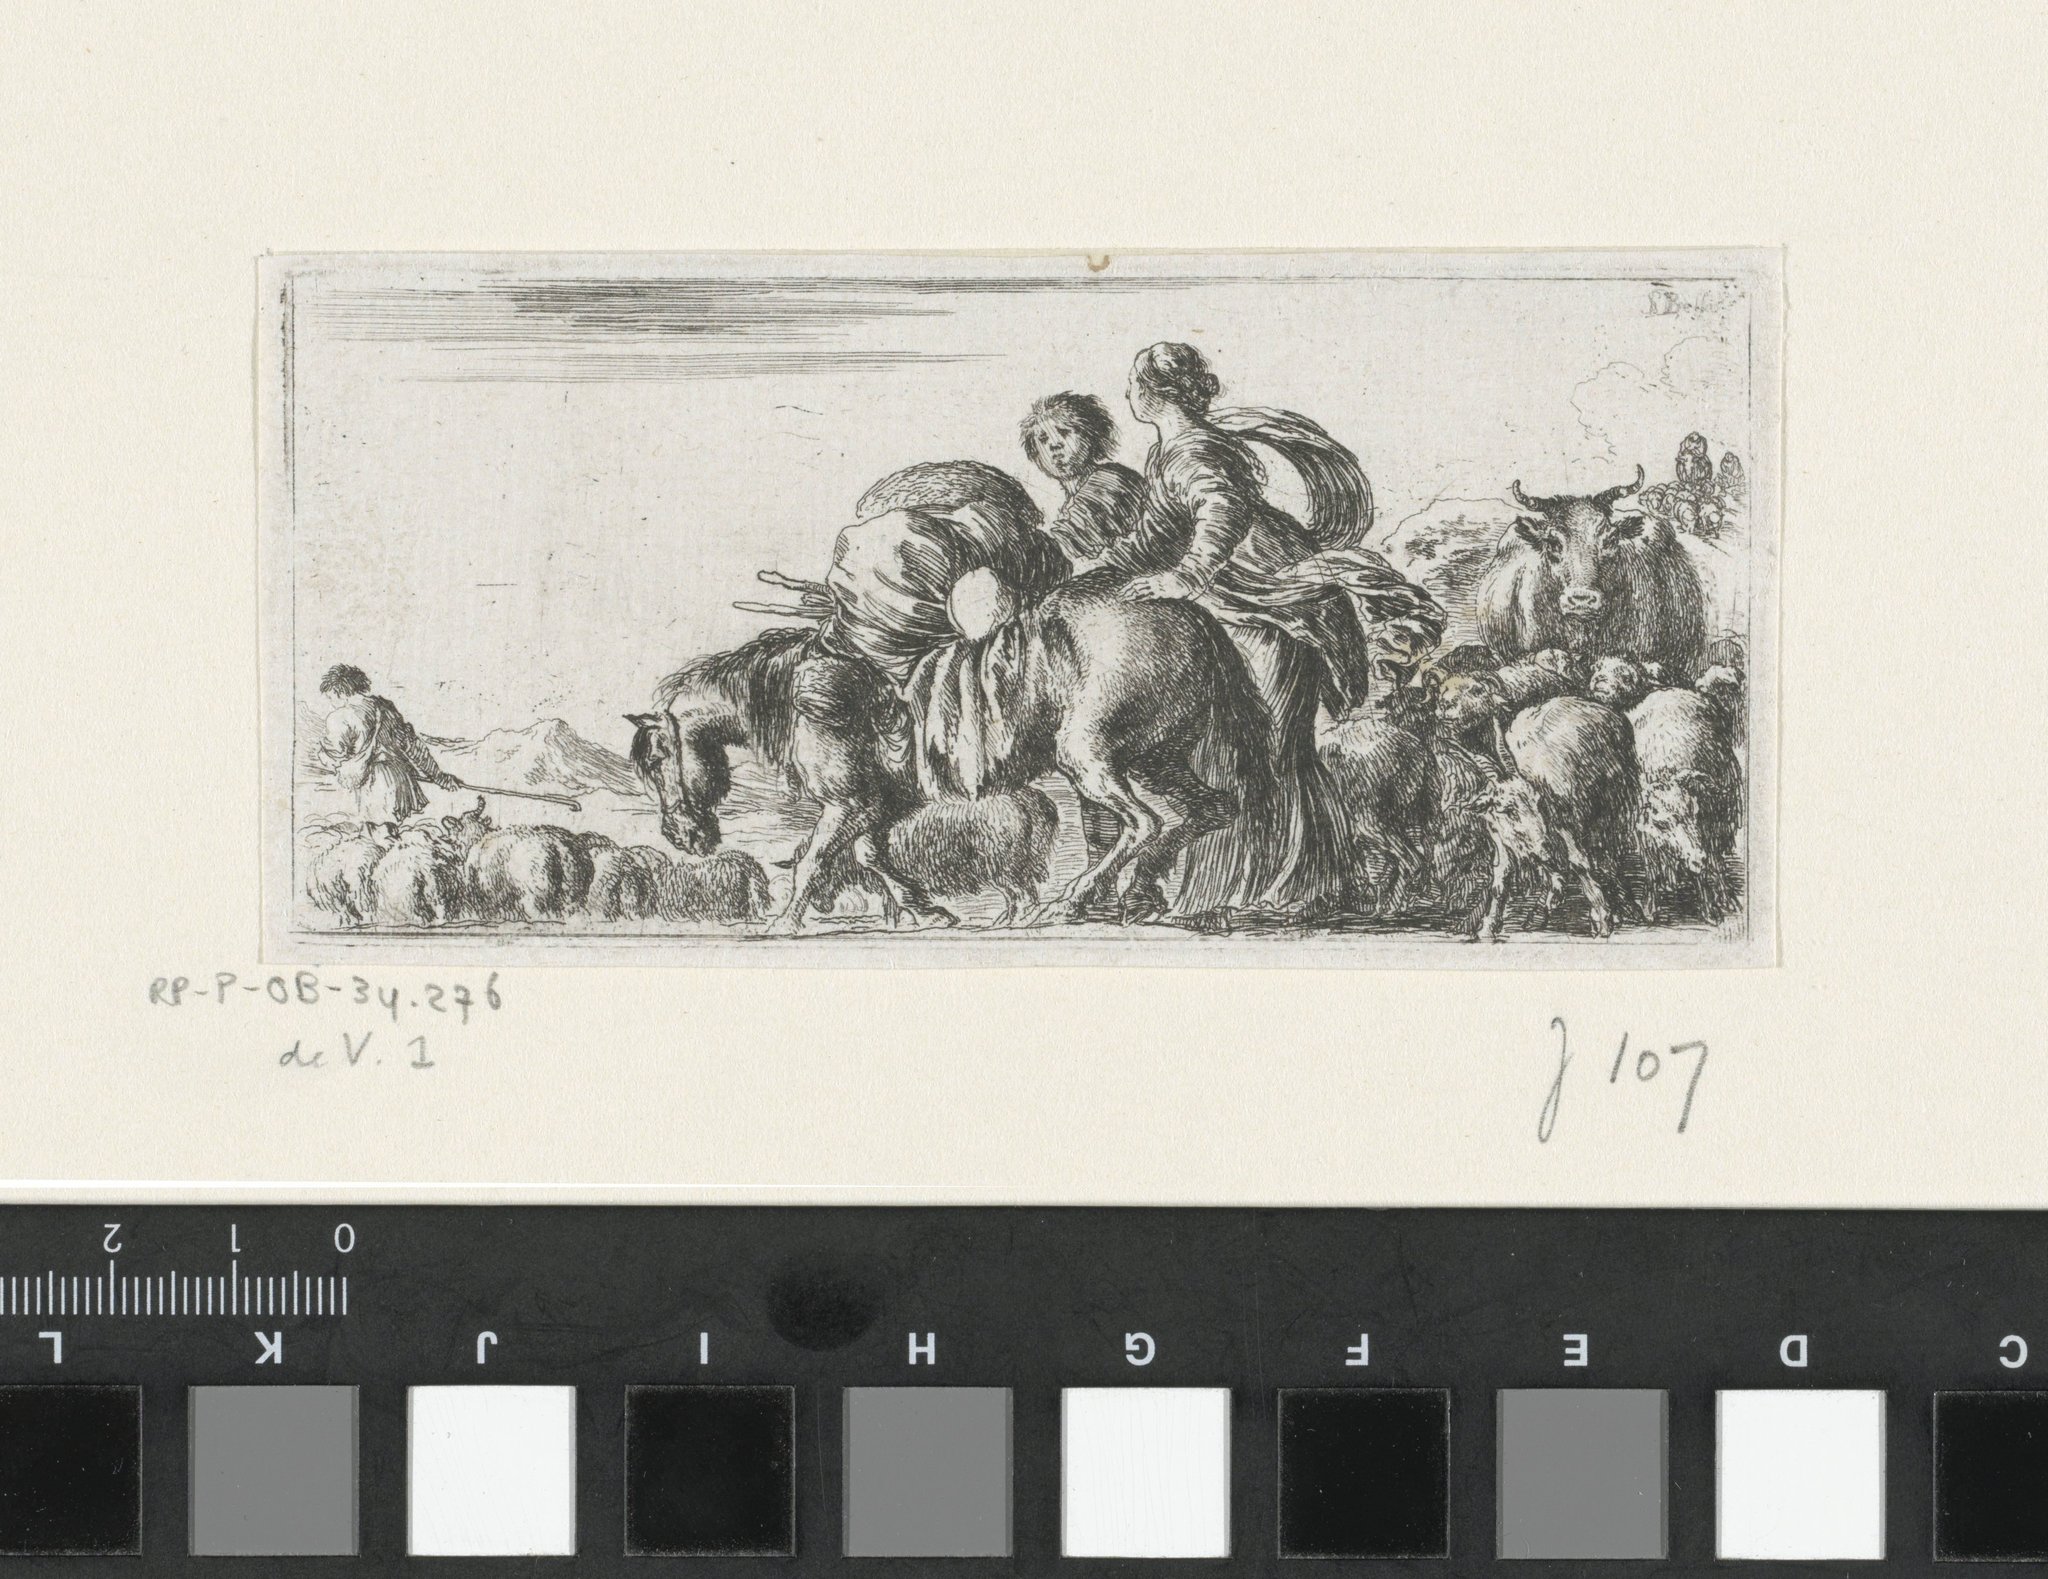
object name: print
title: Jakob en Rachel op weg naar Kanaän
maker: stefano della bella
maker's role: draughtsman, print maker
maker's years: 1610-1664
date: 1620-1664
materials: paper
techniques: etching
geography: italy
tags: jacob on the way to canaan with his family, his flocks, camels and all his possessions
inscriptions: collector's mark: Lugt 240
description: Jakob en Rachel op weg naar Kanaän met een paard, schapen en een koe.